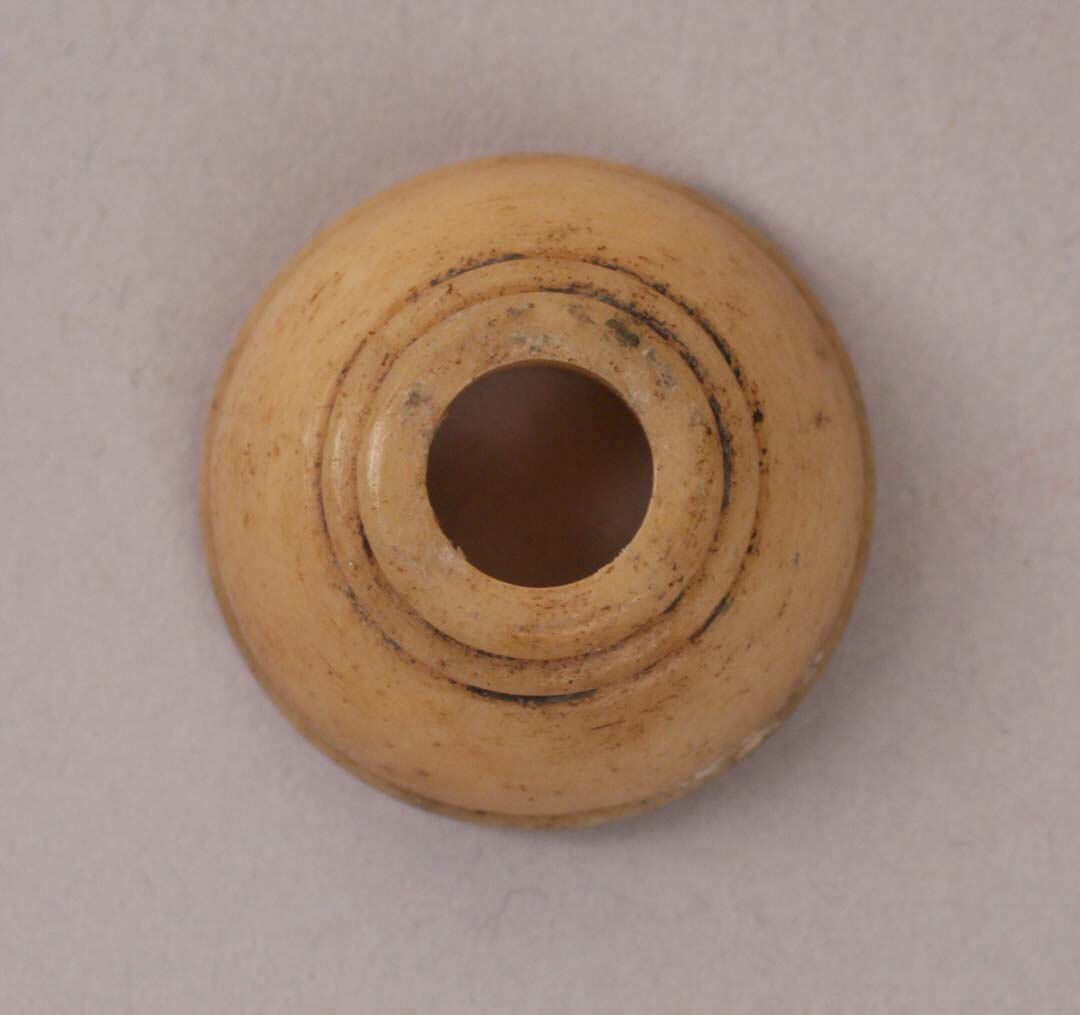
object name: button or bead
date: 801-1000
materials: bone, paint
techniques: incising, inlay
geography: iran